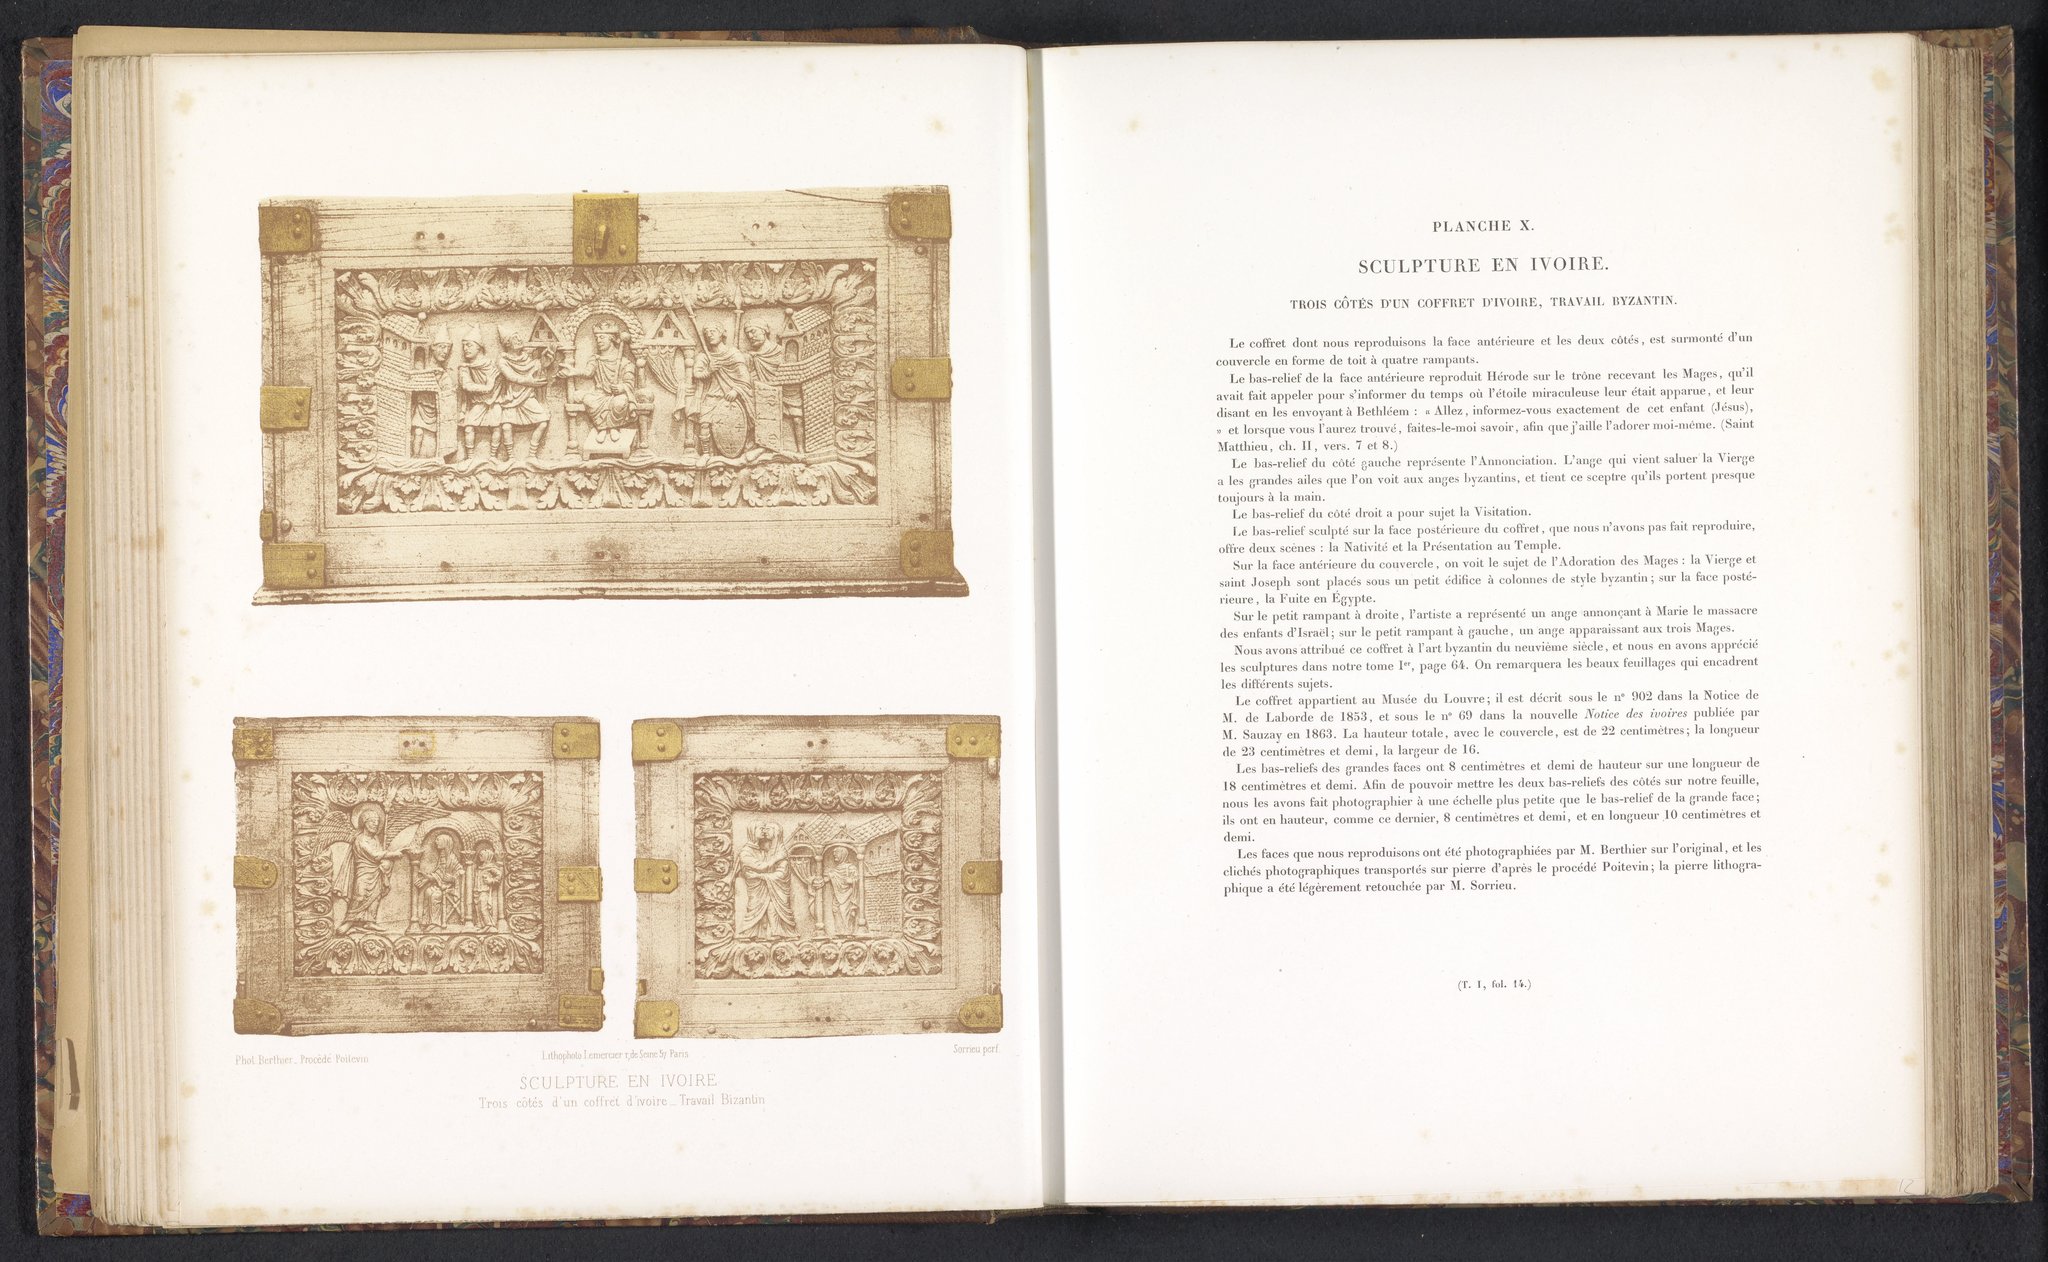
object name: page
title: Drie zijden van een ivoren kist met reliëfs, voorstellende de Annunciatie, de Visitatie en koning Herodes I met de drie koningen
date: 1859-1864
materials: paper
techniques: photolithography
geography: paris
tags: first visit of the three wise men to king herod, mary and elisabeth, both pregnant, embracing, the annunciation: mary sitting, sculpture (+ relief ~ sculpture)